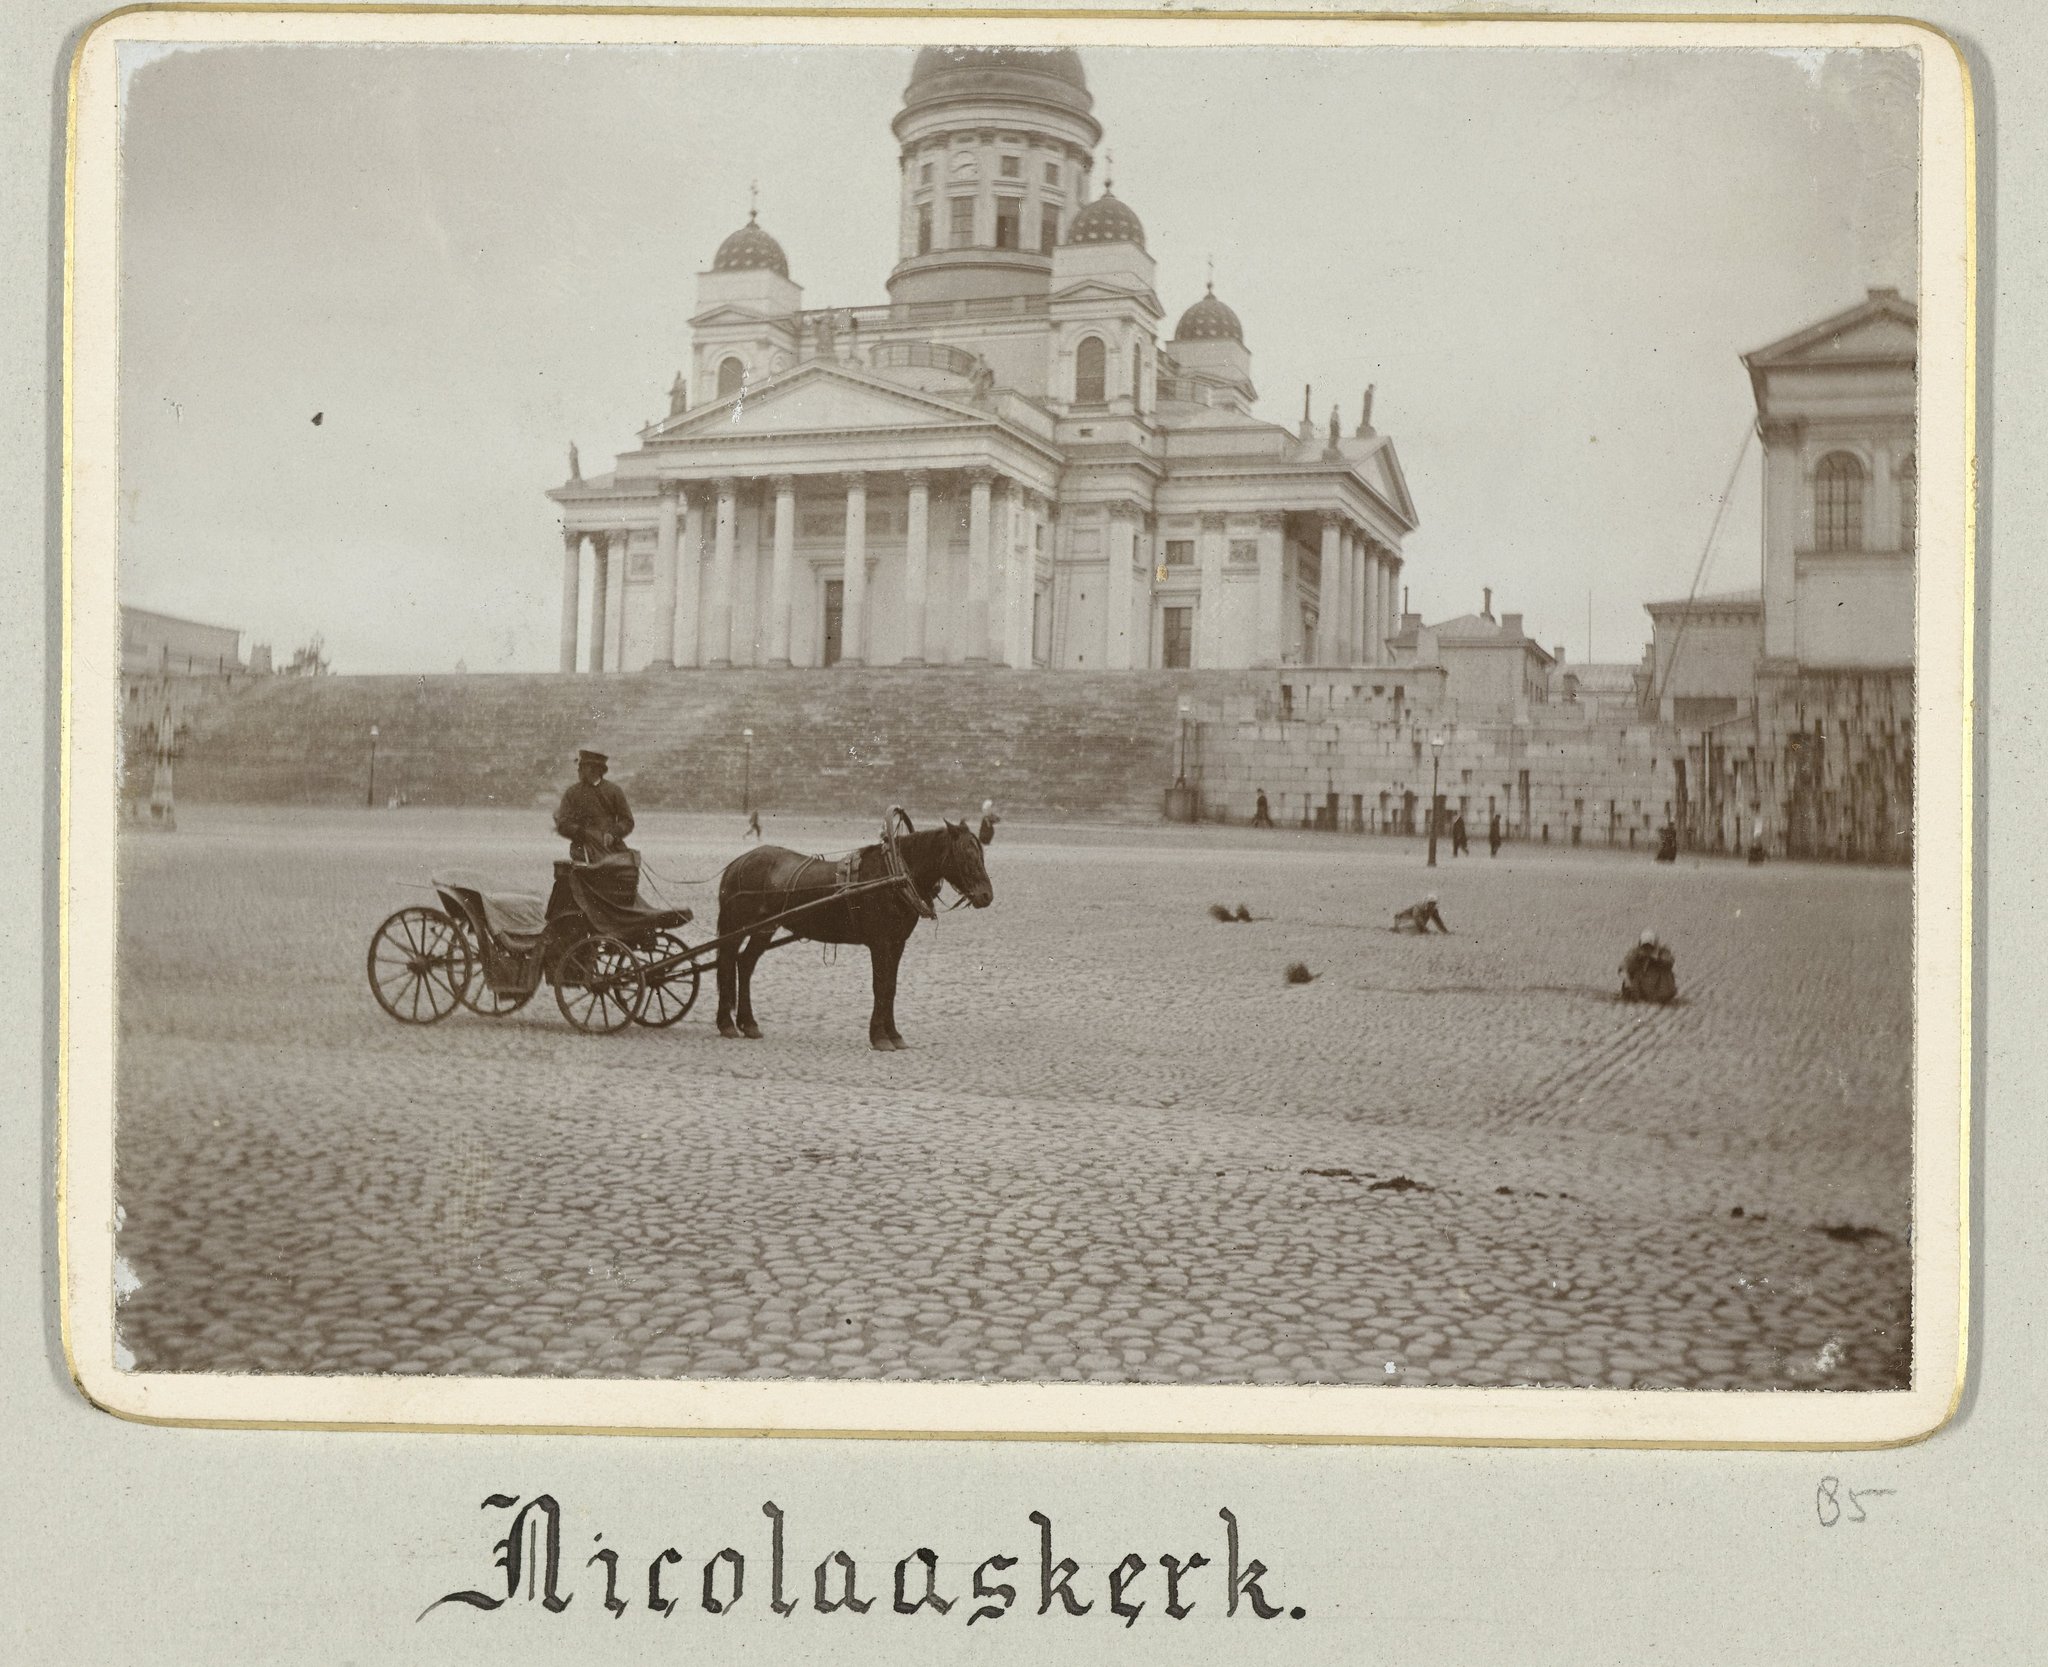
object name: photograph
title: Helsingfors Finland Nicolaaskerk.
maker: henry pauw van wieldrecht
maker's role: fotograaf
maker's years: 1863-1912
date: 1898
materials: paper, photographic support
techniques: albumen print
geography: netherlands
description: De domkerk in Helsinki voorheen tot 1917 ook wel genoemd de Nicolaaskerk naar Tsaar Nicolaas I van Rusland.